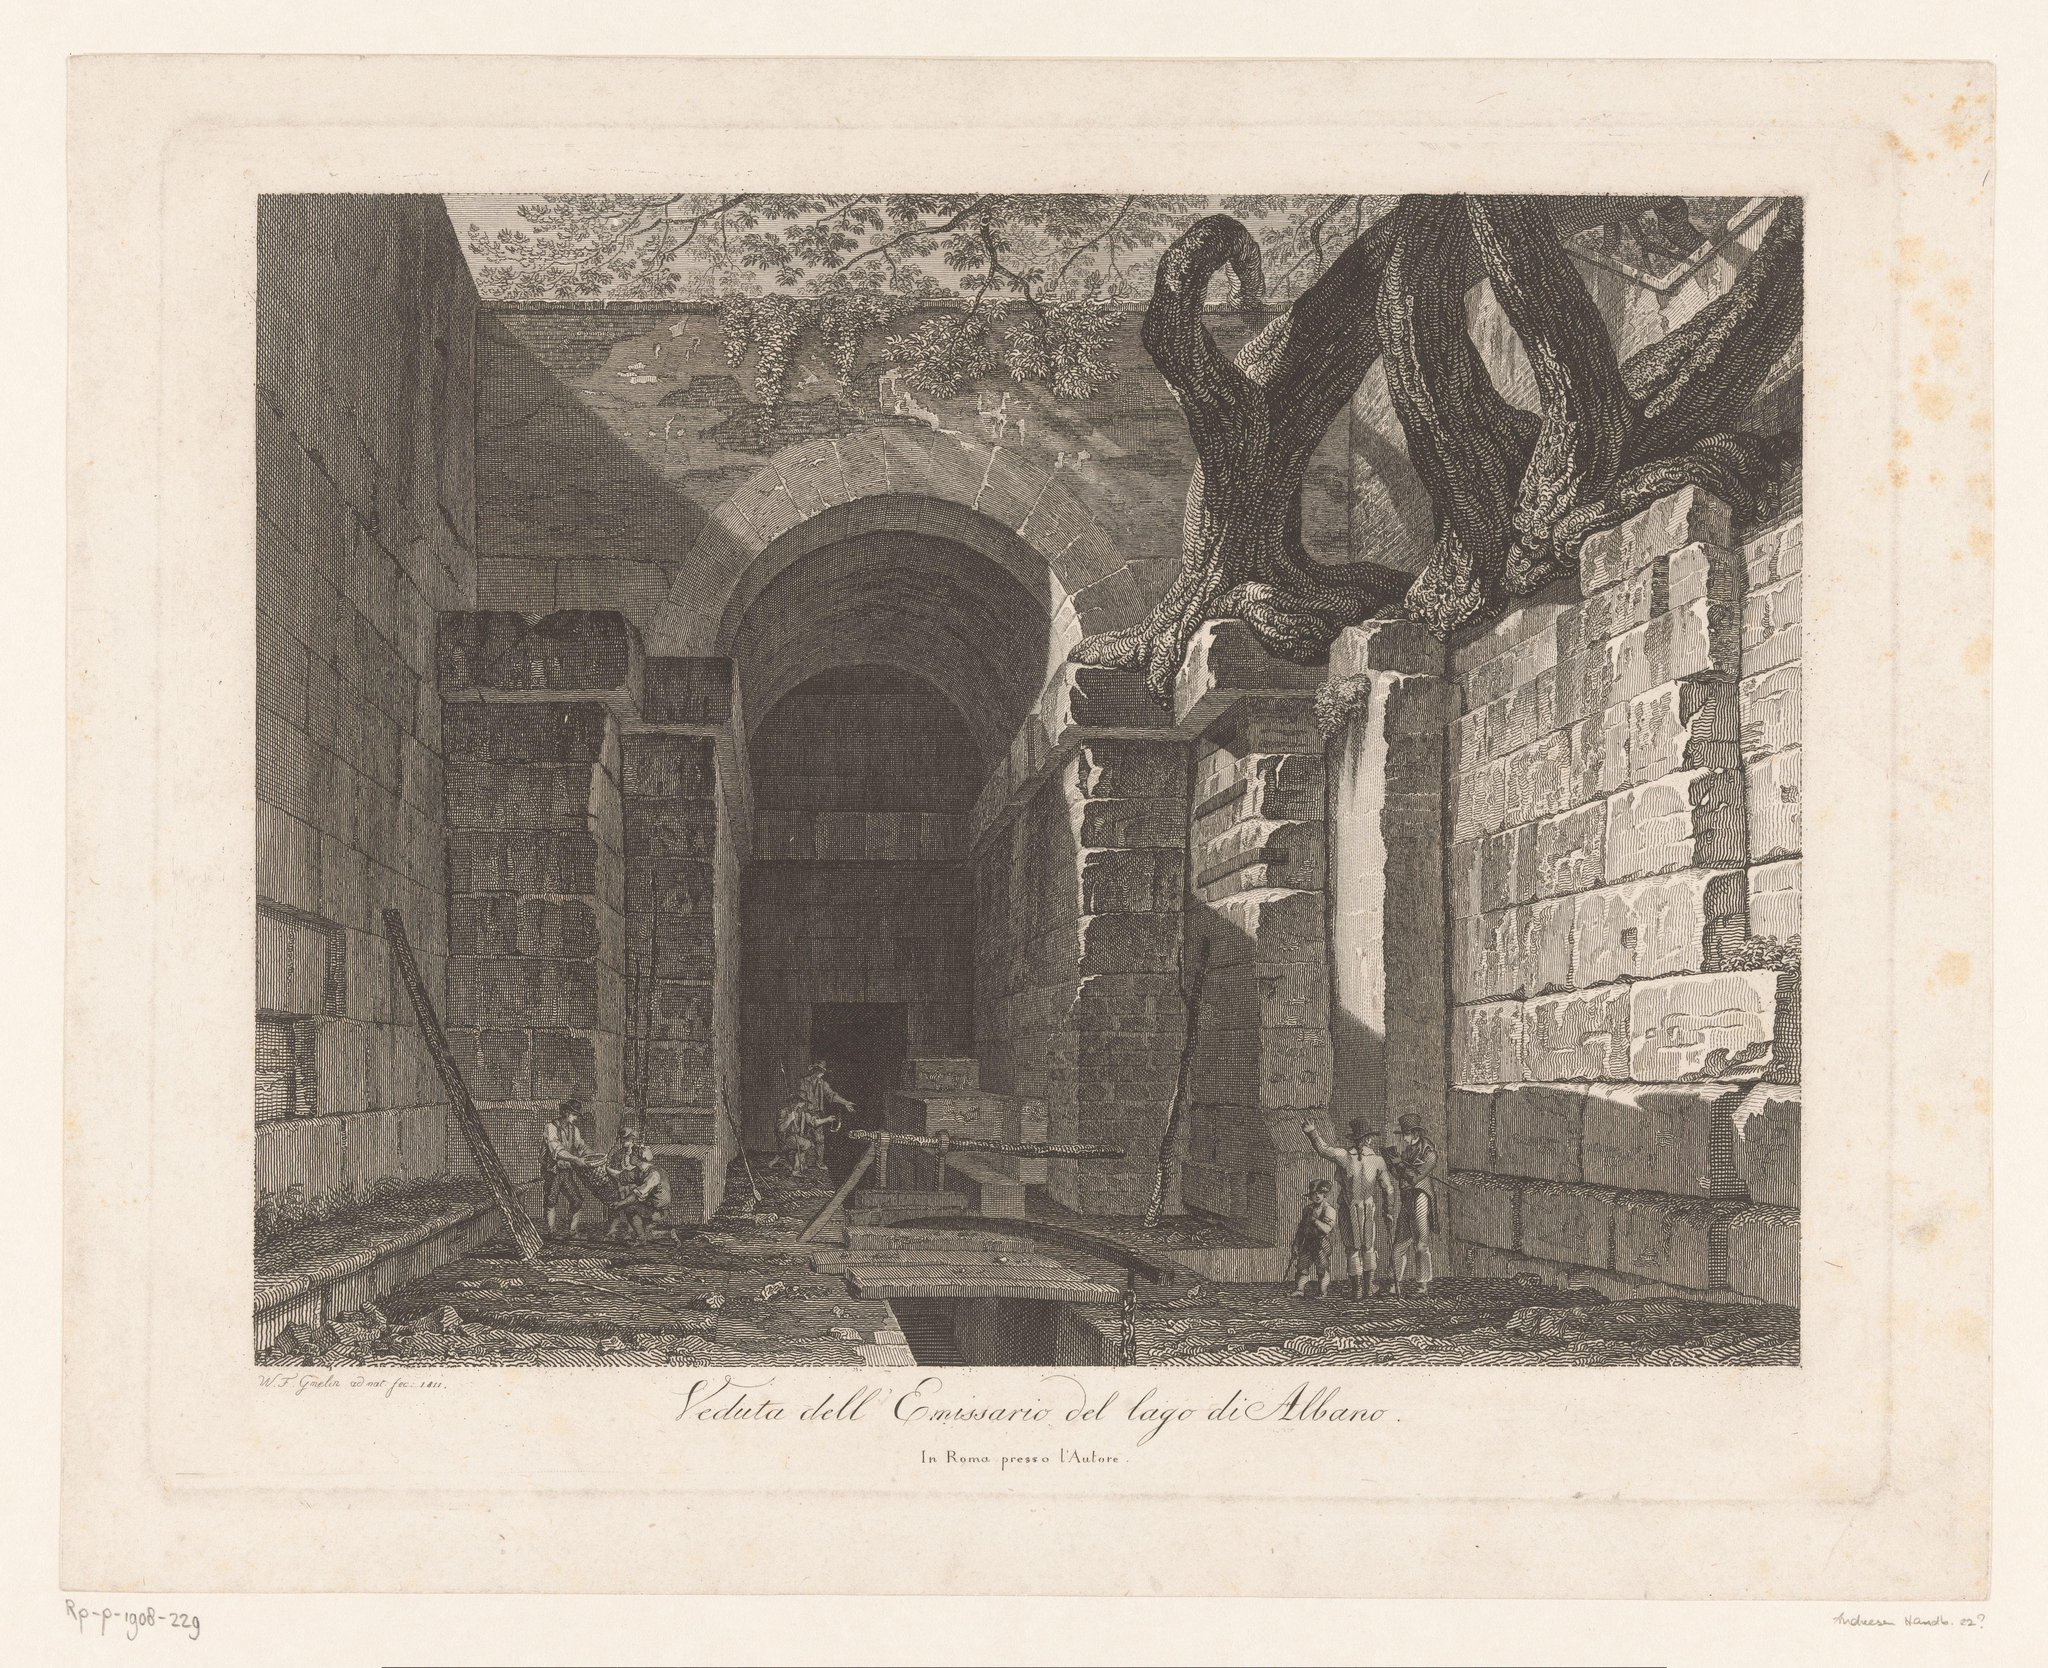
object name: print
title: Gezicht op het afvoerkanaal van het meer bij Albano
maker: wilhelm friedrich gmelin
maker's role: print maker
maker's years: 1760-1820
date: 1811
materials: paper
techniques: etching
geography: rome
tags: sluice, weir, fishing (sports)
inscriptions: collector's mark: Lugt 2228